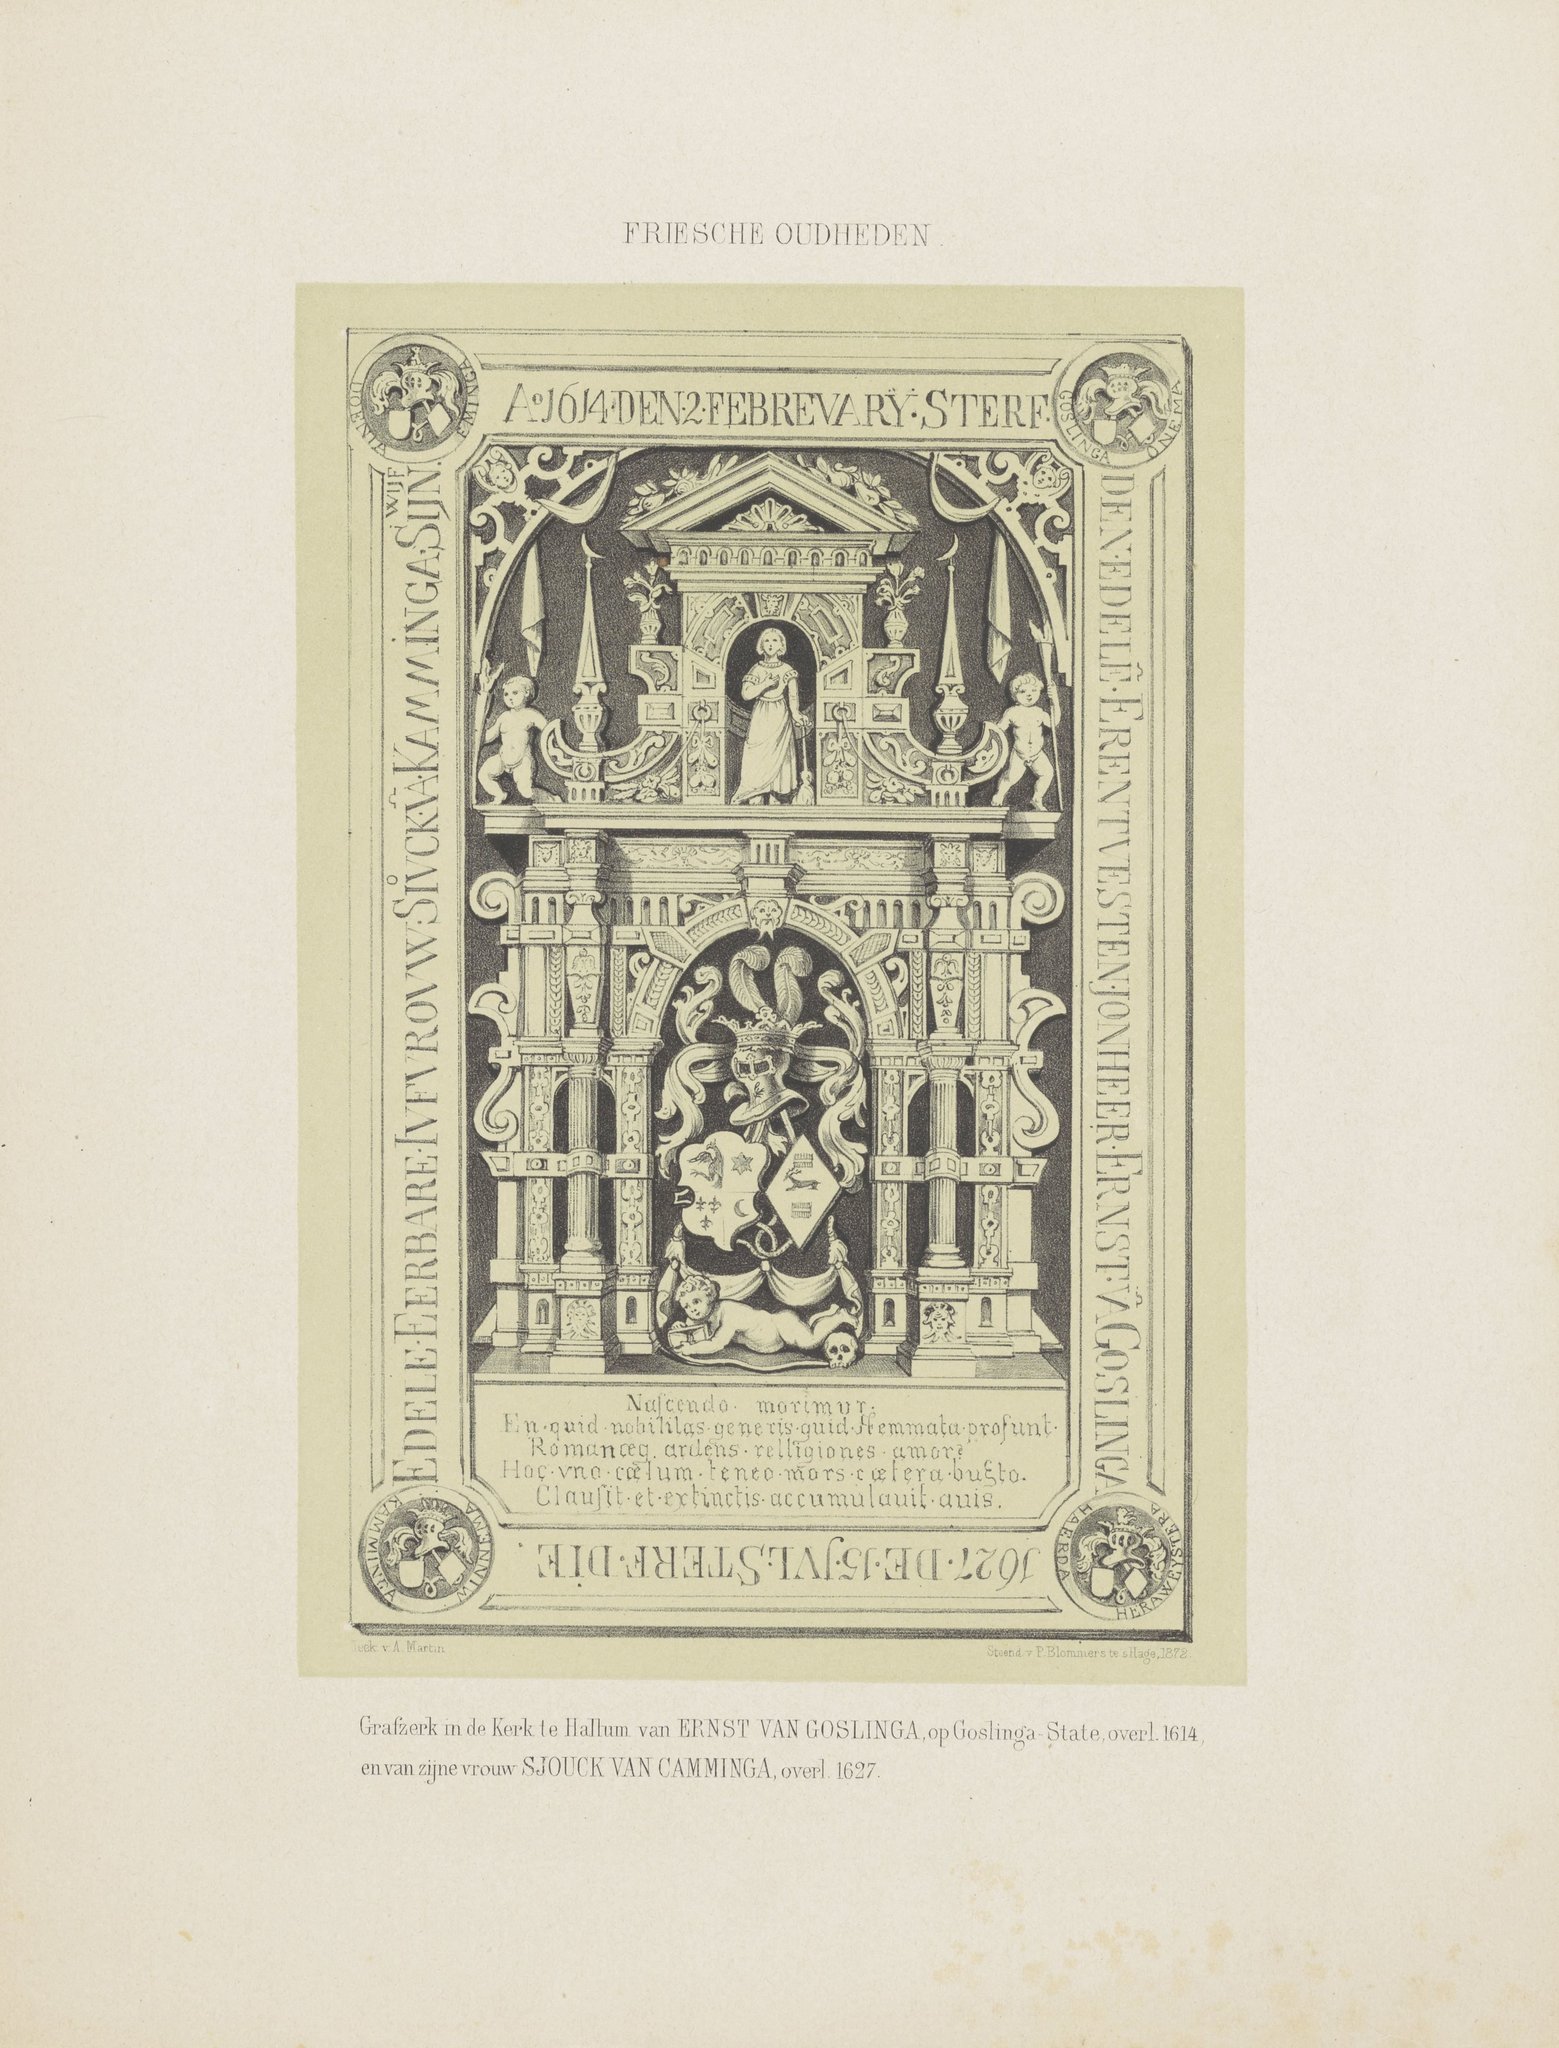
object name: print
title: Grafzerk in de kerk te Hallum van Ernst van Goslinga (...)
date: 1872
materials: paper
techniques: lithograph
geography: the hague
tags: cupids: 'amores', 'amoretti', 'putti', armorial bearing, heraldry, flat, horizontal gravestone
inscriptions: collector's mark: Lugt 2228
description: Prent uit: S.n. Friesche oudheden. Afbeeldingen van merkwaardige voorwerpen van wetenschap en kunst gevonden in de archieven, kerken, kasteelen, terpen enz. van Friesland. Leeuwarden: Kuipers, H., 1875.